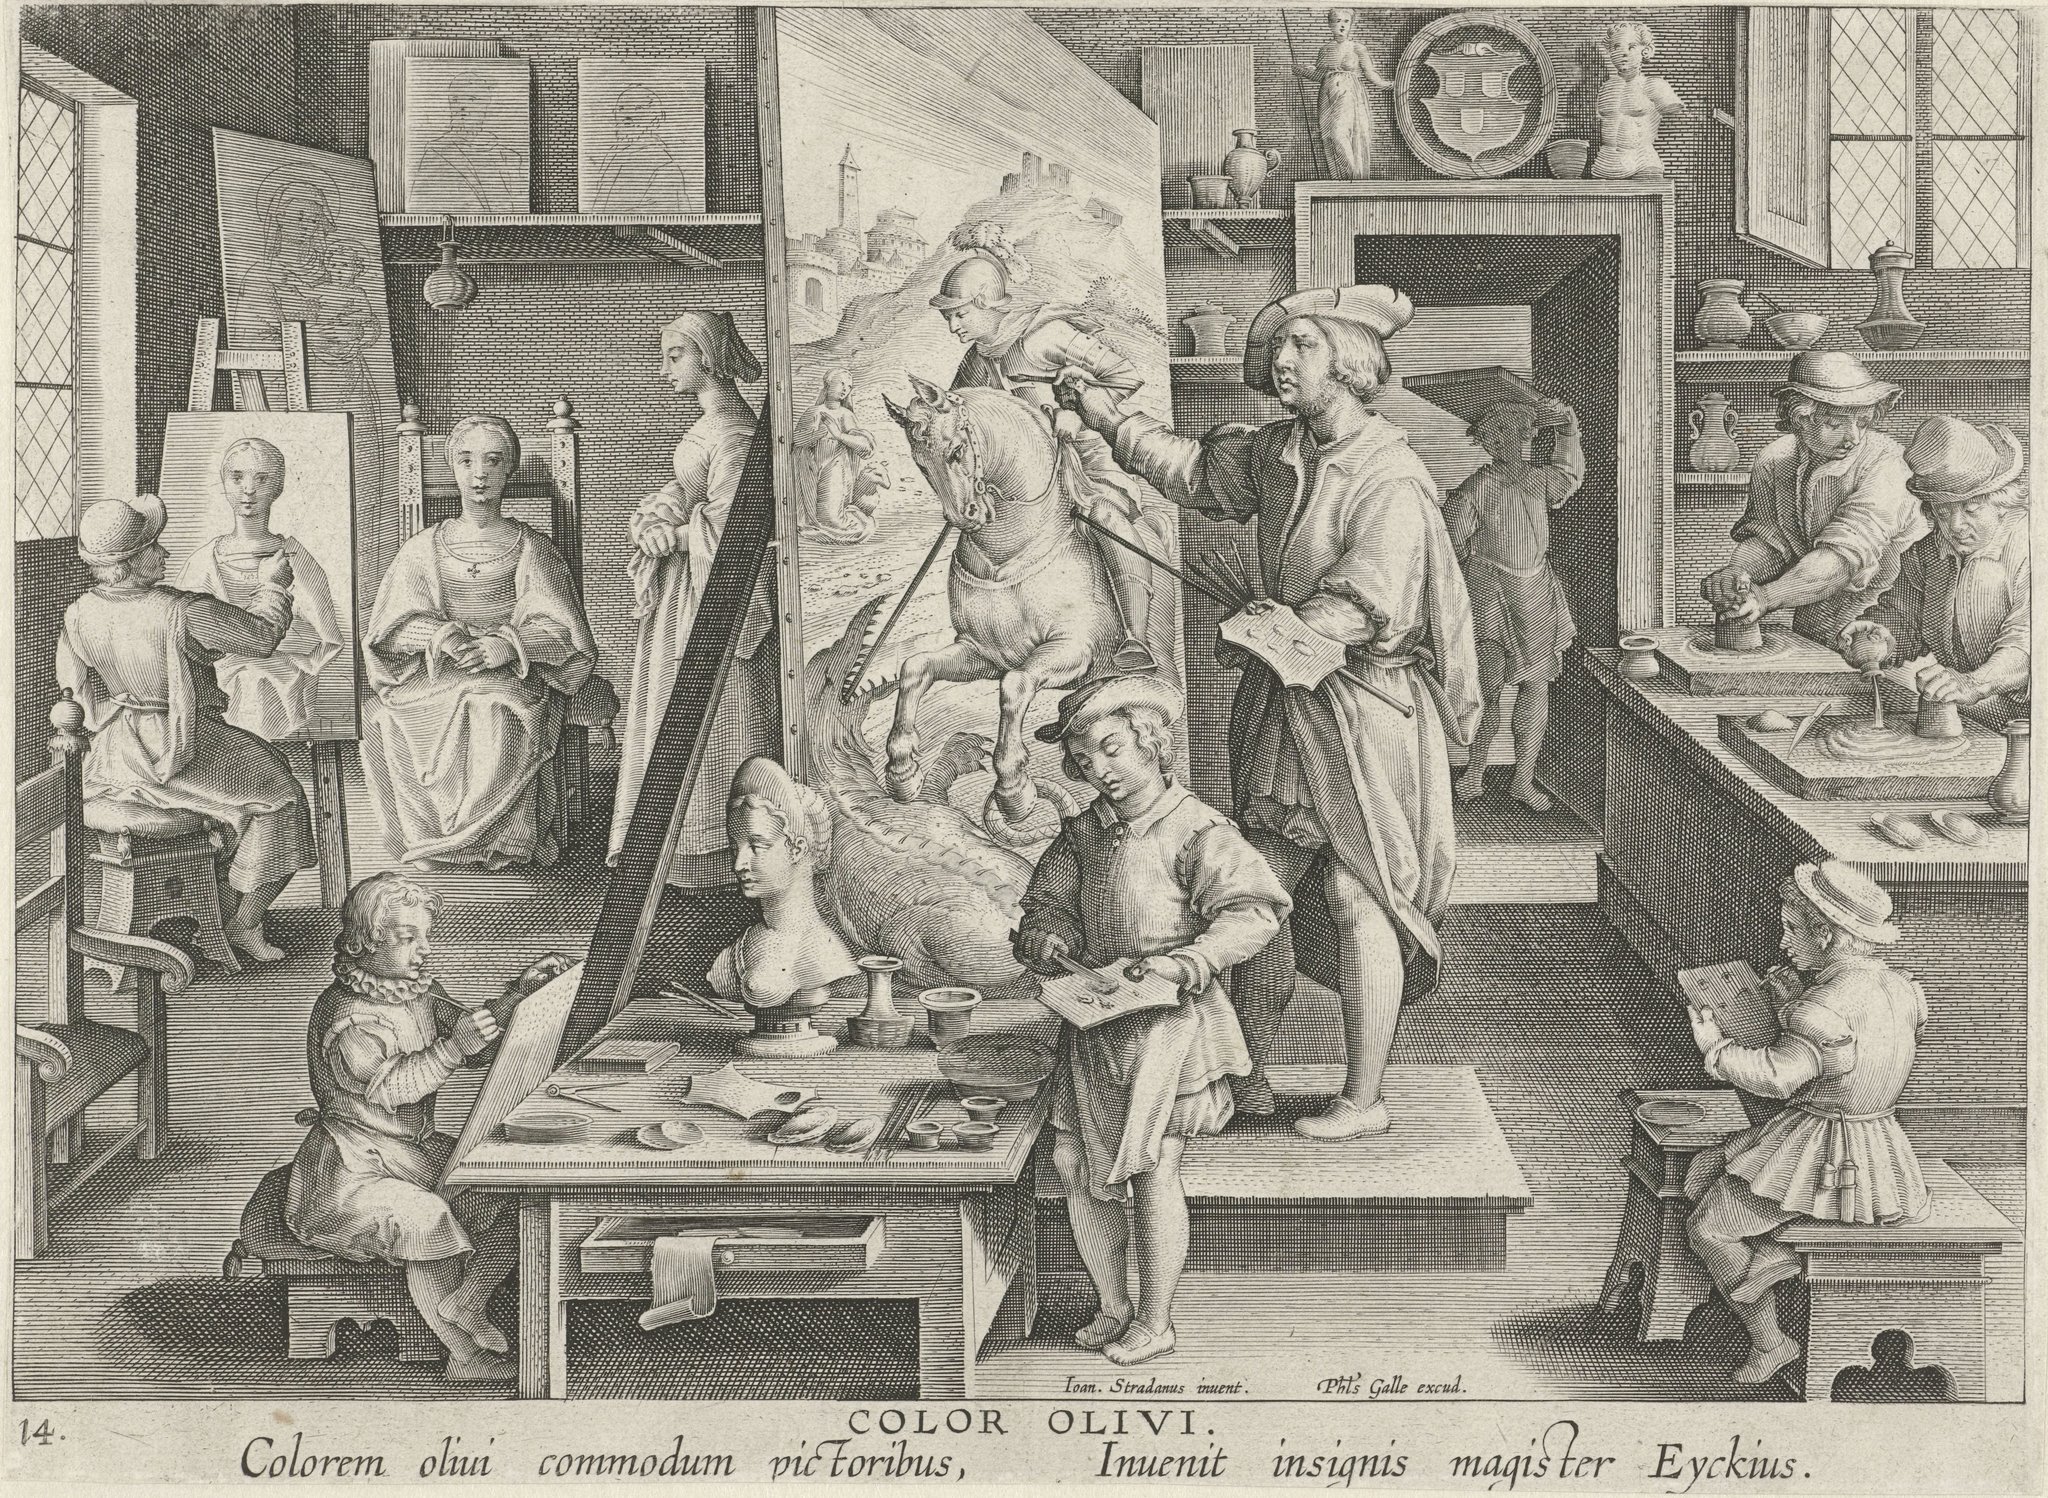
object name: print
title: Nieuwe uitvindingen en ontdekkingen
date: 1589-1593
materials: paper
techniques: engraving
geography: antwerp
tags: bruges, draughtsman, jan van eyck, st. george and the dragon: dressed in armour and mounted on a (white) horse he brandishes his sword (his lance lies already broken on the ground); the princess nearby may be shown praying or fleeing, workshop, studio ~ painter, painter at work with assistants or pupils, model, sitter ~ painting, painter preparing colours, invention, discovery ~ science and technology, painting of cloth (+ oil ~ crafts, industries, agriculture), painter training pupils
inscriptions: collector's mark: Lugt 2228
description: Tot een van de belangrijke uitvindingen na de Oudheid rekende men in de 16de eeuw die van de olieverf. Deze uitvinding werd, zoals het onderschrift vermeldt, aan de 15de-eeuwse schilder Jan van Eijck toegeschreven. De gravure geeft de verschillende werkzaamheden weer in een schilderswerkplaats in de tweede helft van de 16de eeuw: knechten of leerlingen wrijven de verf, die eigenhandig in de werkplaats werd bereid door de droge kleurstoffen met olie te mengen. Een leerling brengt de verf aan op het palet van de meester, die de laatste hand legt aan het grote doek waarop St.Joris en de draak zijn afgebeeld. Een gezel schildert een poserende dame en de jongste leerlingen houden zich bezig met tekenen, de eerste stap in de opleiding tot schilder. De prent heeft een Latijns onderschrift en maakt deel uit van een negentiendelige serie over nieuwe uitvindingen en ontdekkingen.